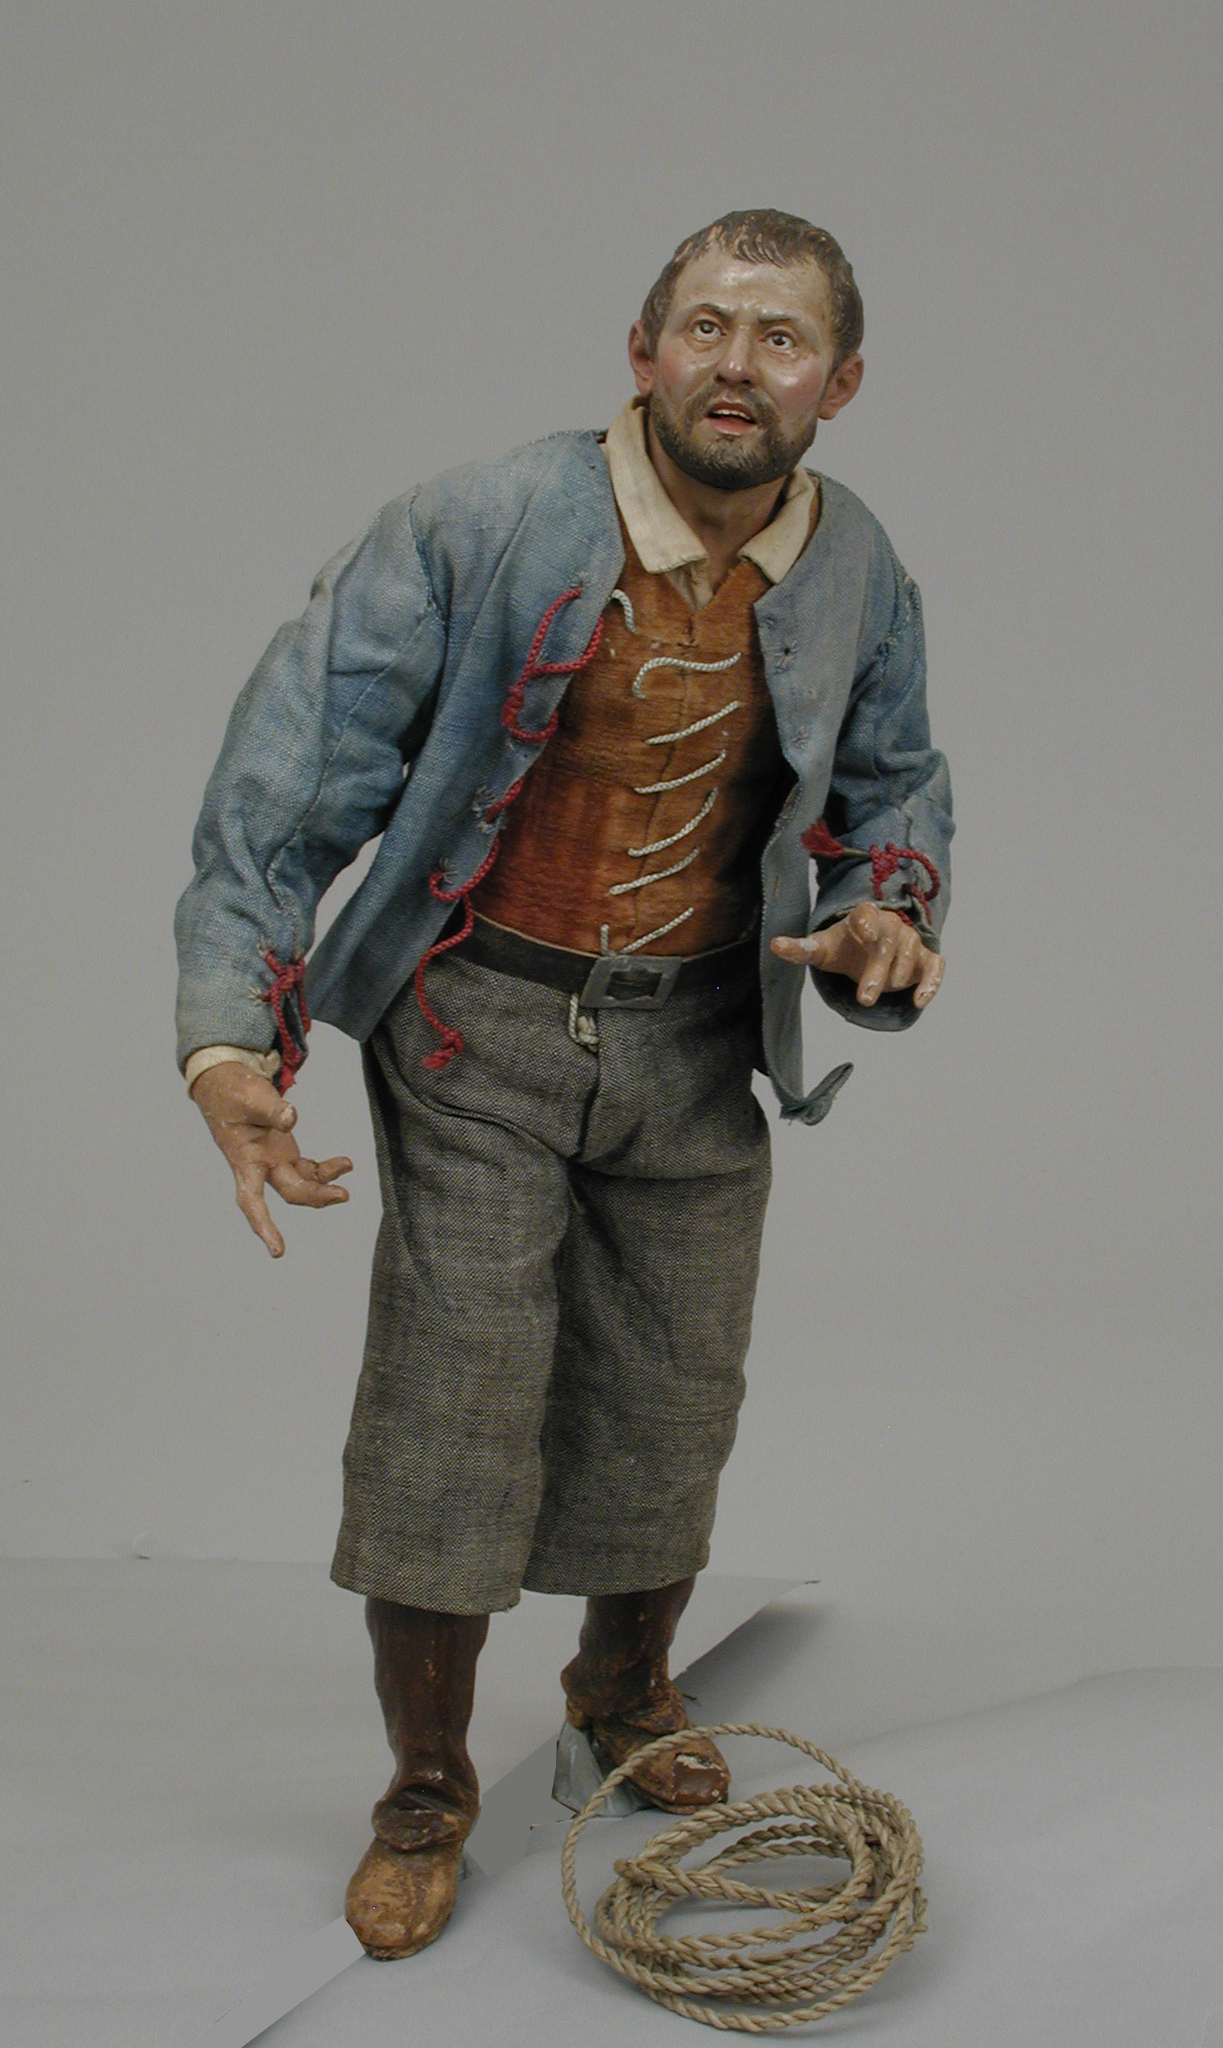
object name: crèche figure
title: Shepherd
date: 1751-1800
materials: cotton, leather, metal, terracotta, fiber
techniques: polychrome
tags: men,shepherds